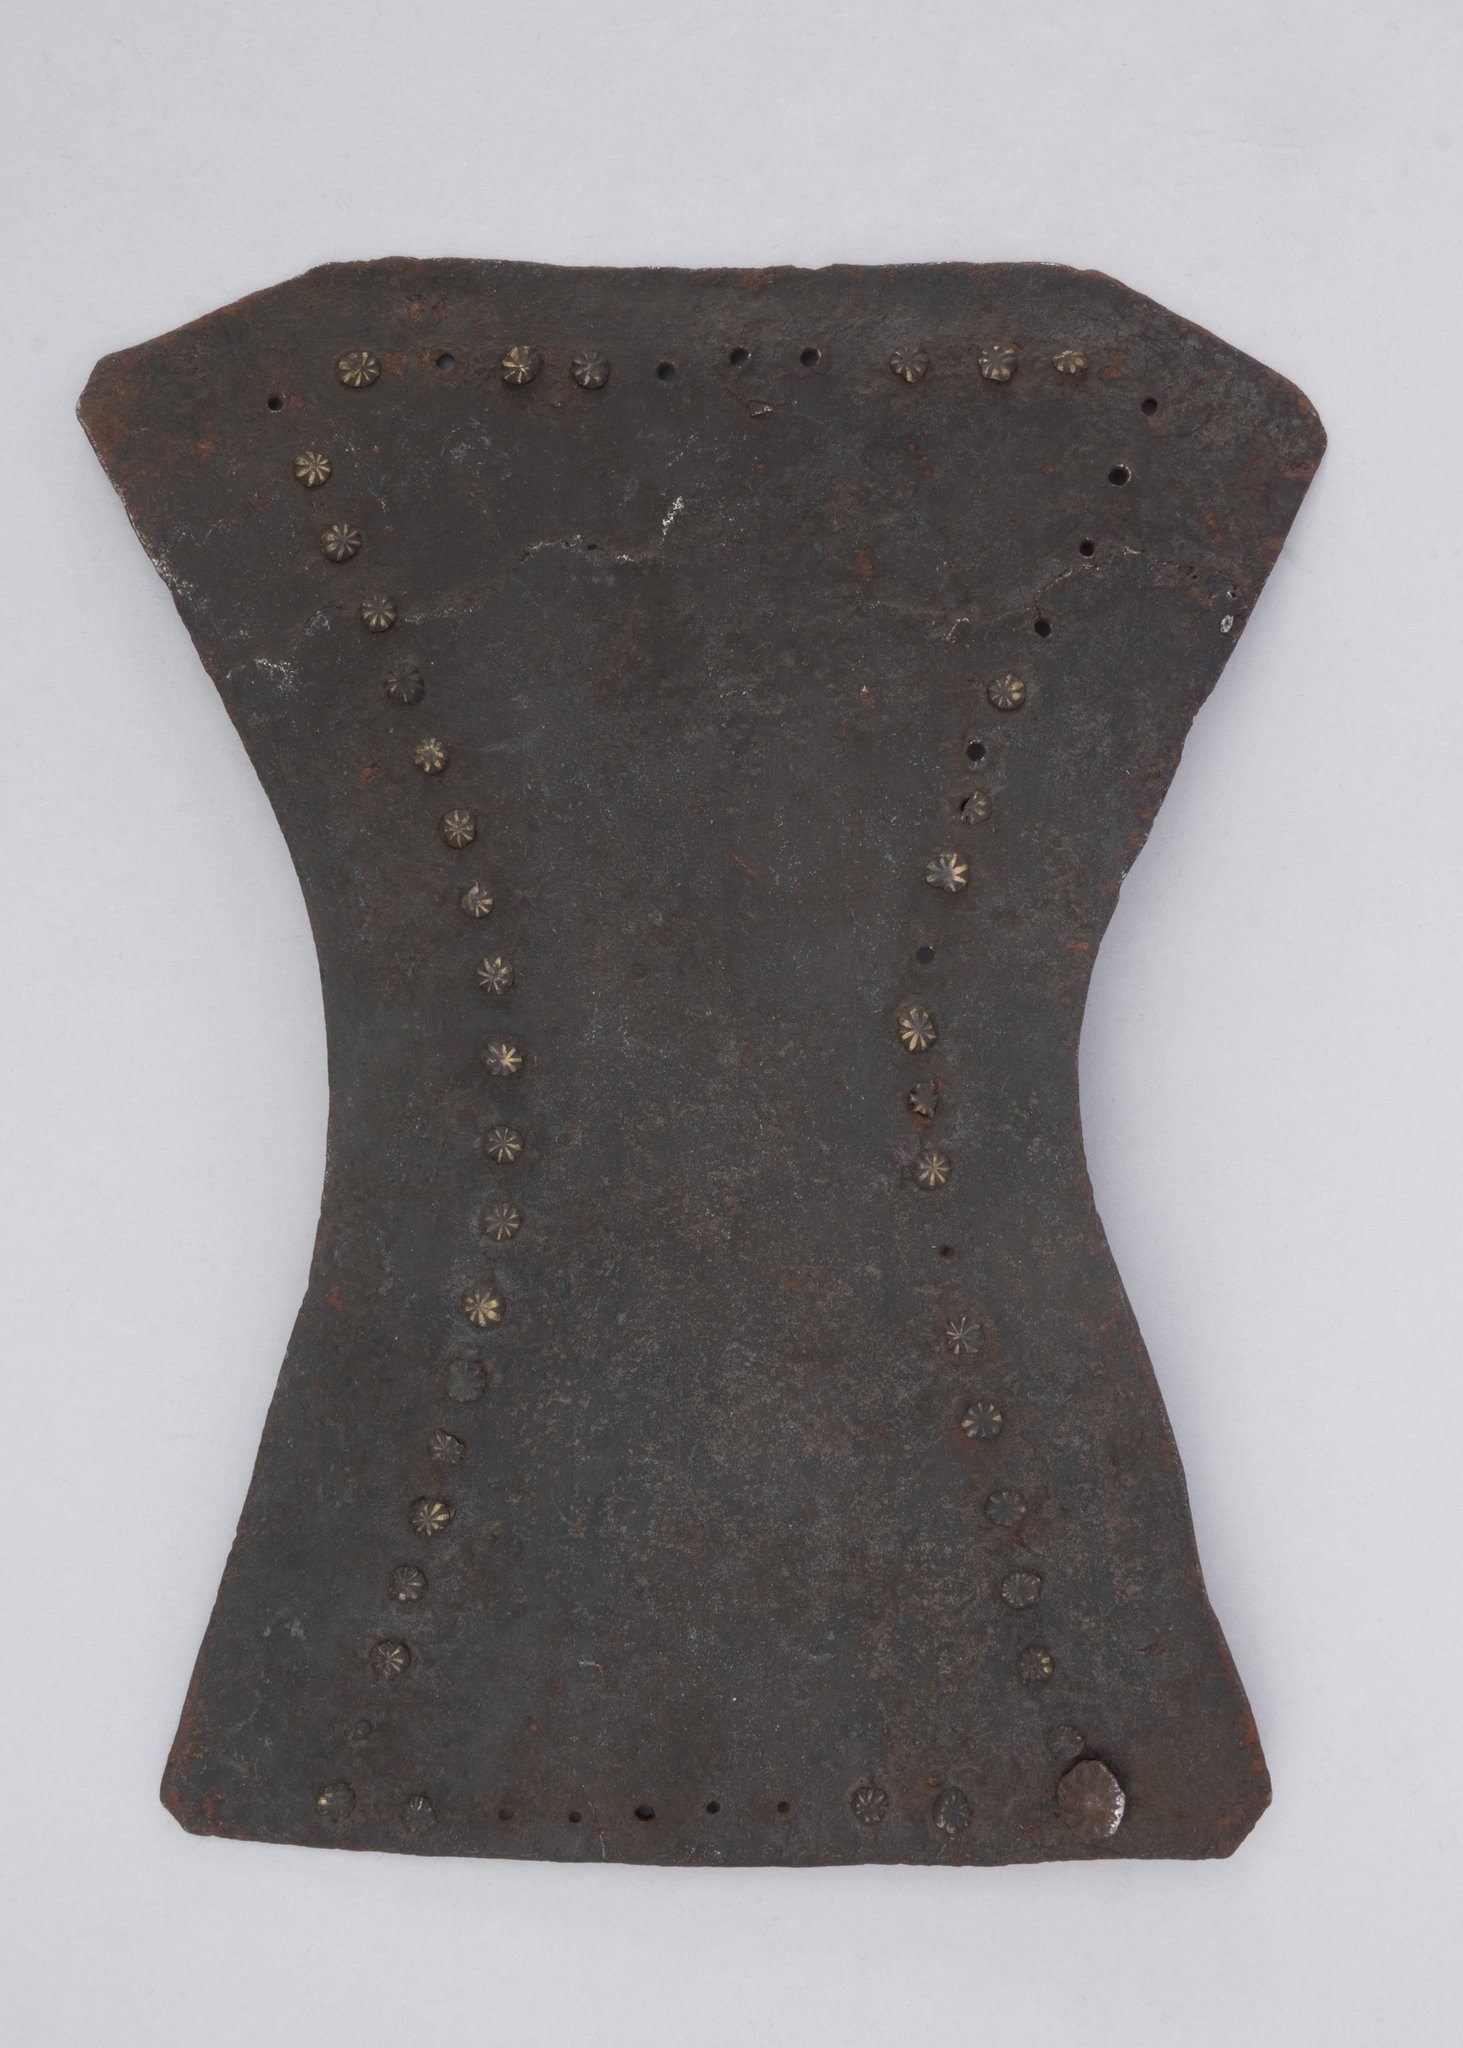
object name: brigandine plate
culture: italian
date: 1400-1450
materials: copper alloy, metal alloy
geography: italy